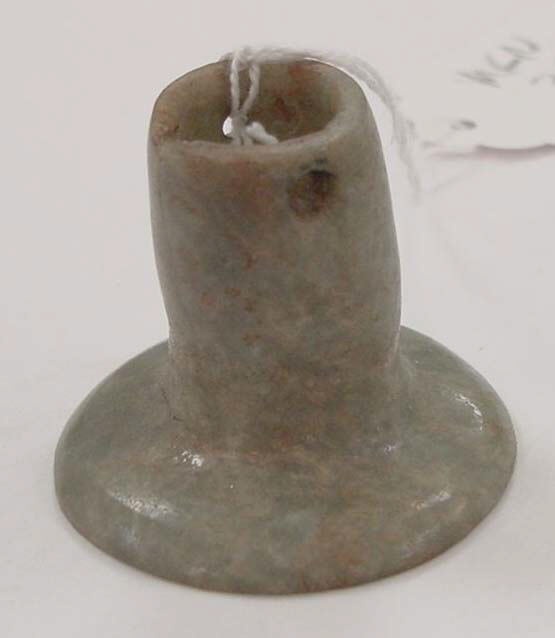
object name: ear ornament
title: Ear ornaments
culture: indigenous american, pre-columbian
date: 500 BCE-900 CE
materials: jade